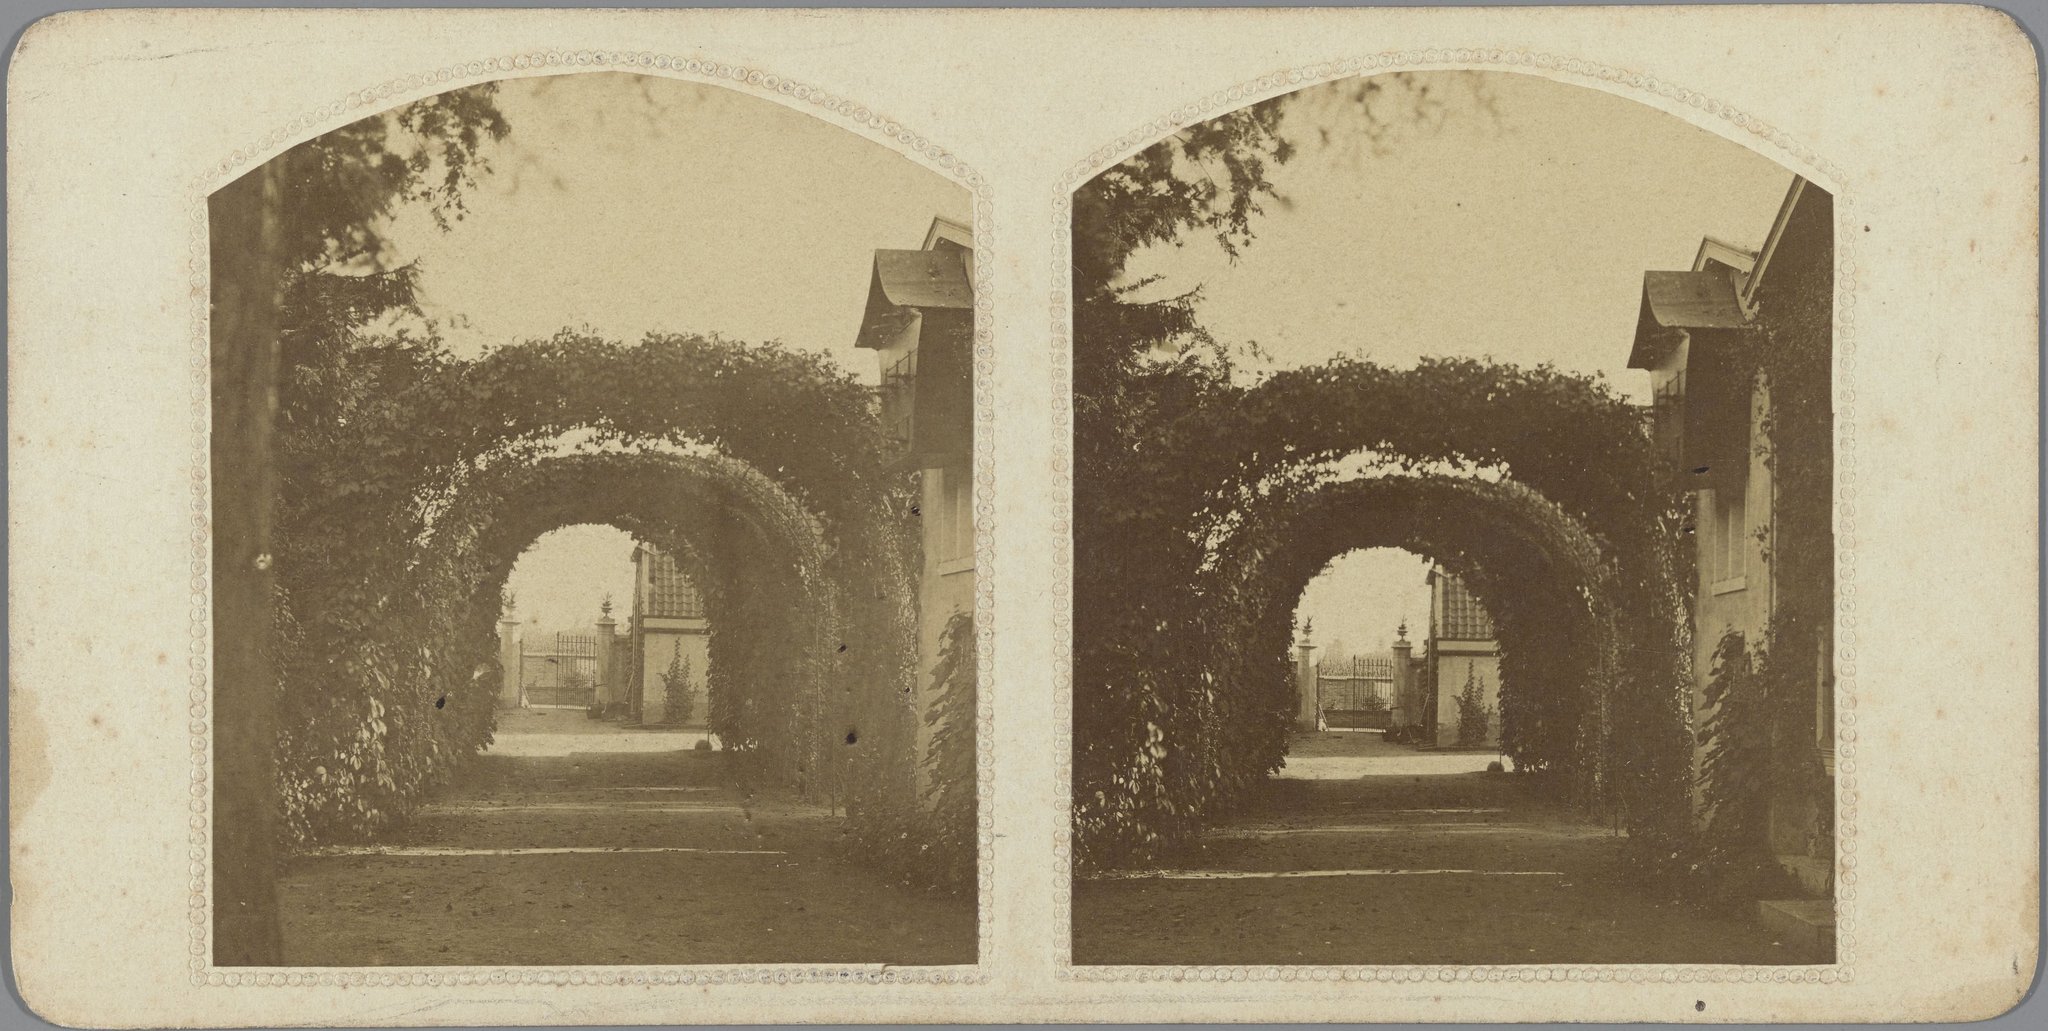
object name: stereograph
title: Loofgang (berceau) met aan het einde een hek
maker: Anonymous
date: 1860-1880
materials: cardboard, paper, photographic support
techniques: albumen print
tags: garden, gate, entrance